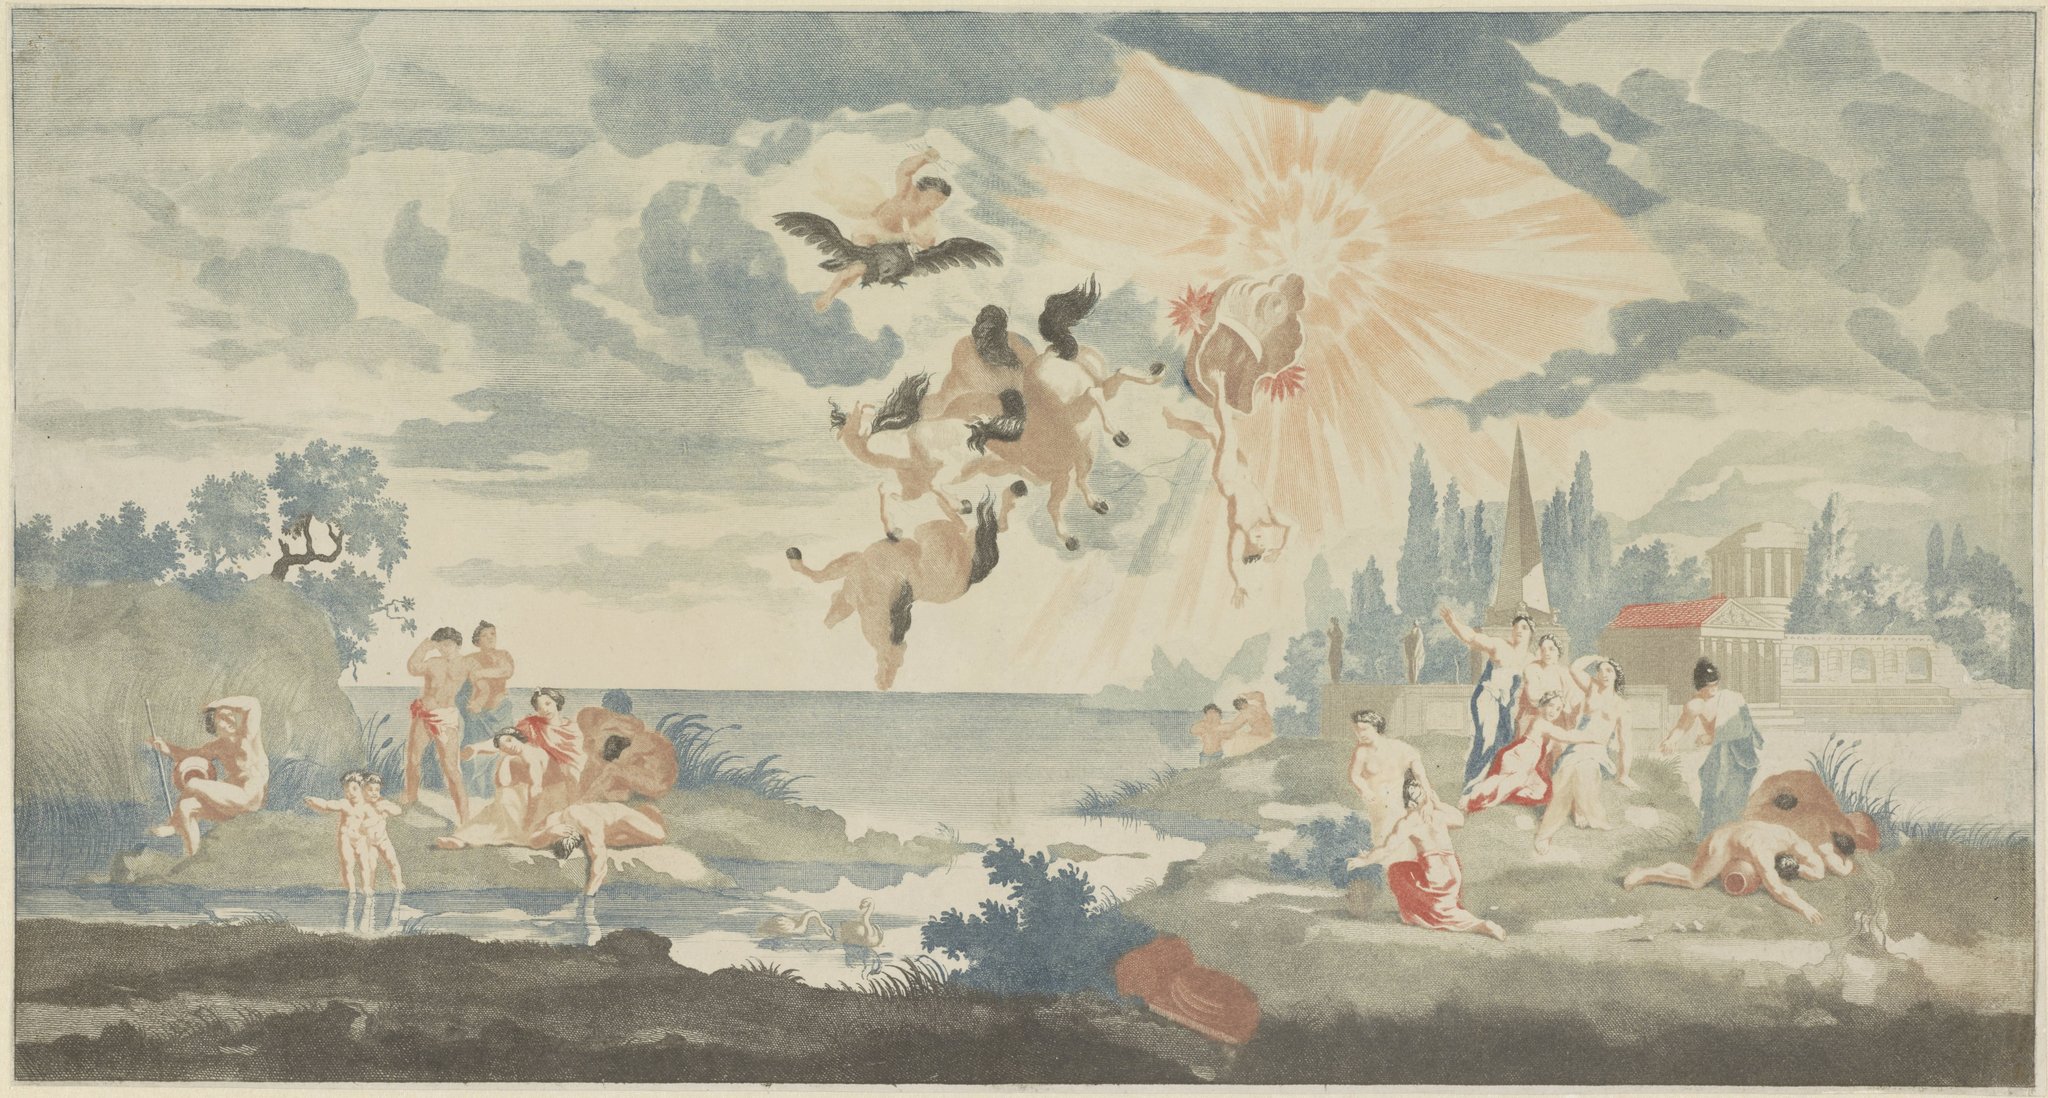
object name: print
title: Val van Phaëthon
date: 1688-1698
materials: paper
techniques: engraving, etching, lithography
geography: netherlands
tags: fall of phaethon; he is struck by a thunderbolt of jupiter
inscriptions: collector's mark: Lugt 2760, collector's mark: Lugt 2228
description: Phaëthon stort met de zonnewagen en paarden uit de lucht in het water, nadat Jupiter hem met een bliksemschicht heeft geraakt. Op het land kijken nimfen en riviergoden verschrikt toe. Enkele riviergoden liggen getroffen voorover over hun urn.